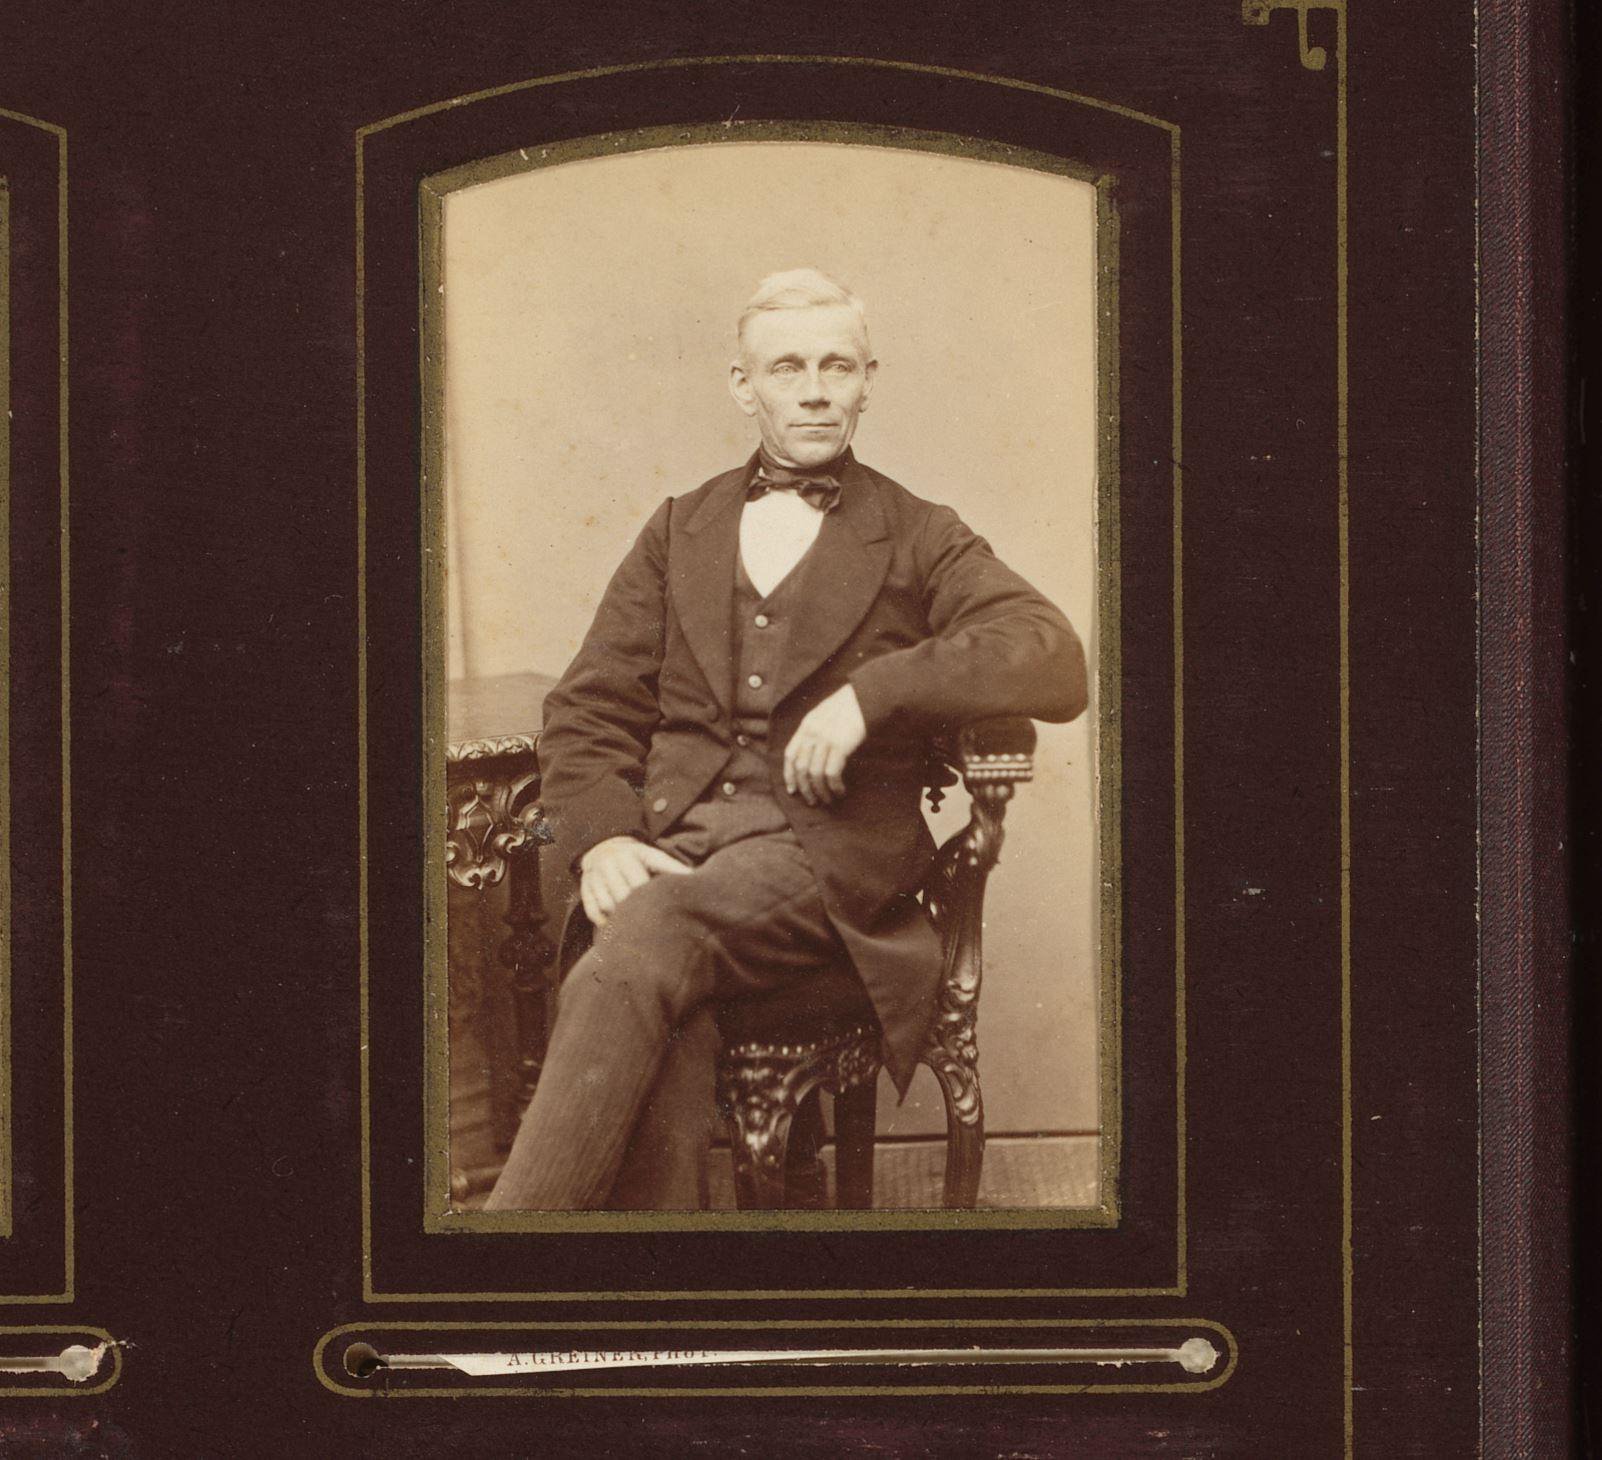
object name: carte de visite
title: Portret van een man, zittend op een stoel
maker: albert greiner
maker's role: fotograaf, fotostudio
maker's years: 1833-1890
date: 1861-1874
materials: cardboard, photographic support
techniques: albumen print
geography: amsterdam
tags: historical persons, chair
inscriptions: inscription: ‘A. Greiner/ Photograf/ NIEUWENDIJK L. 87/ AMSTERDAM’